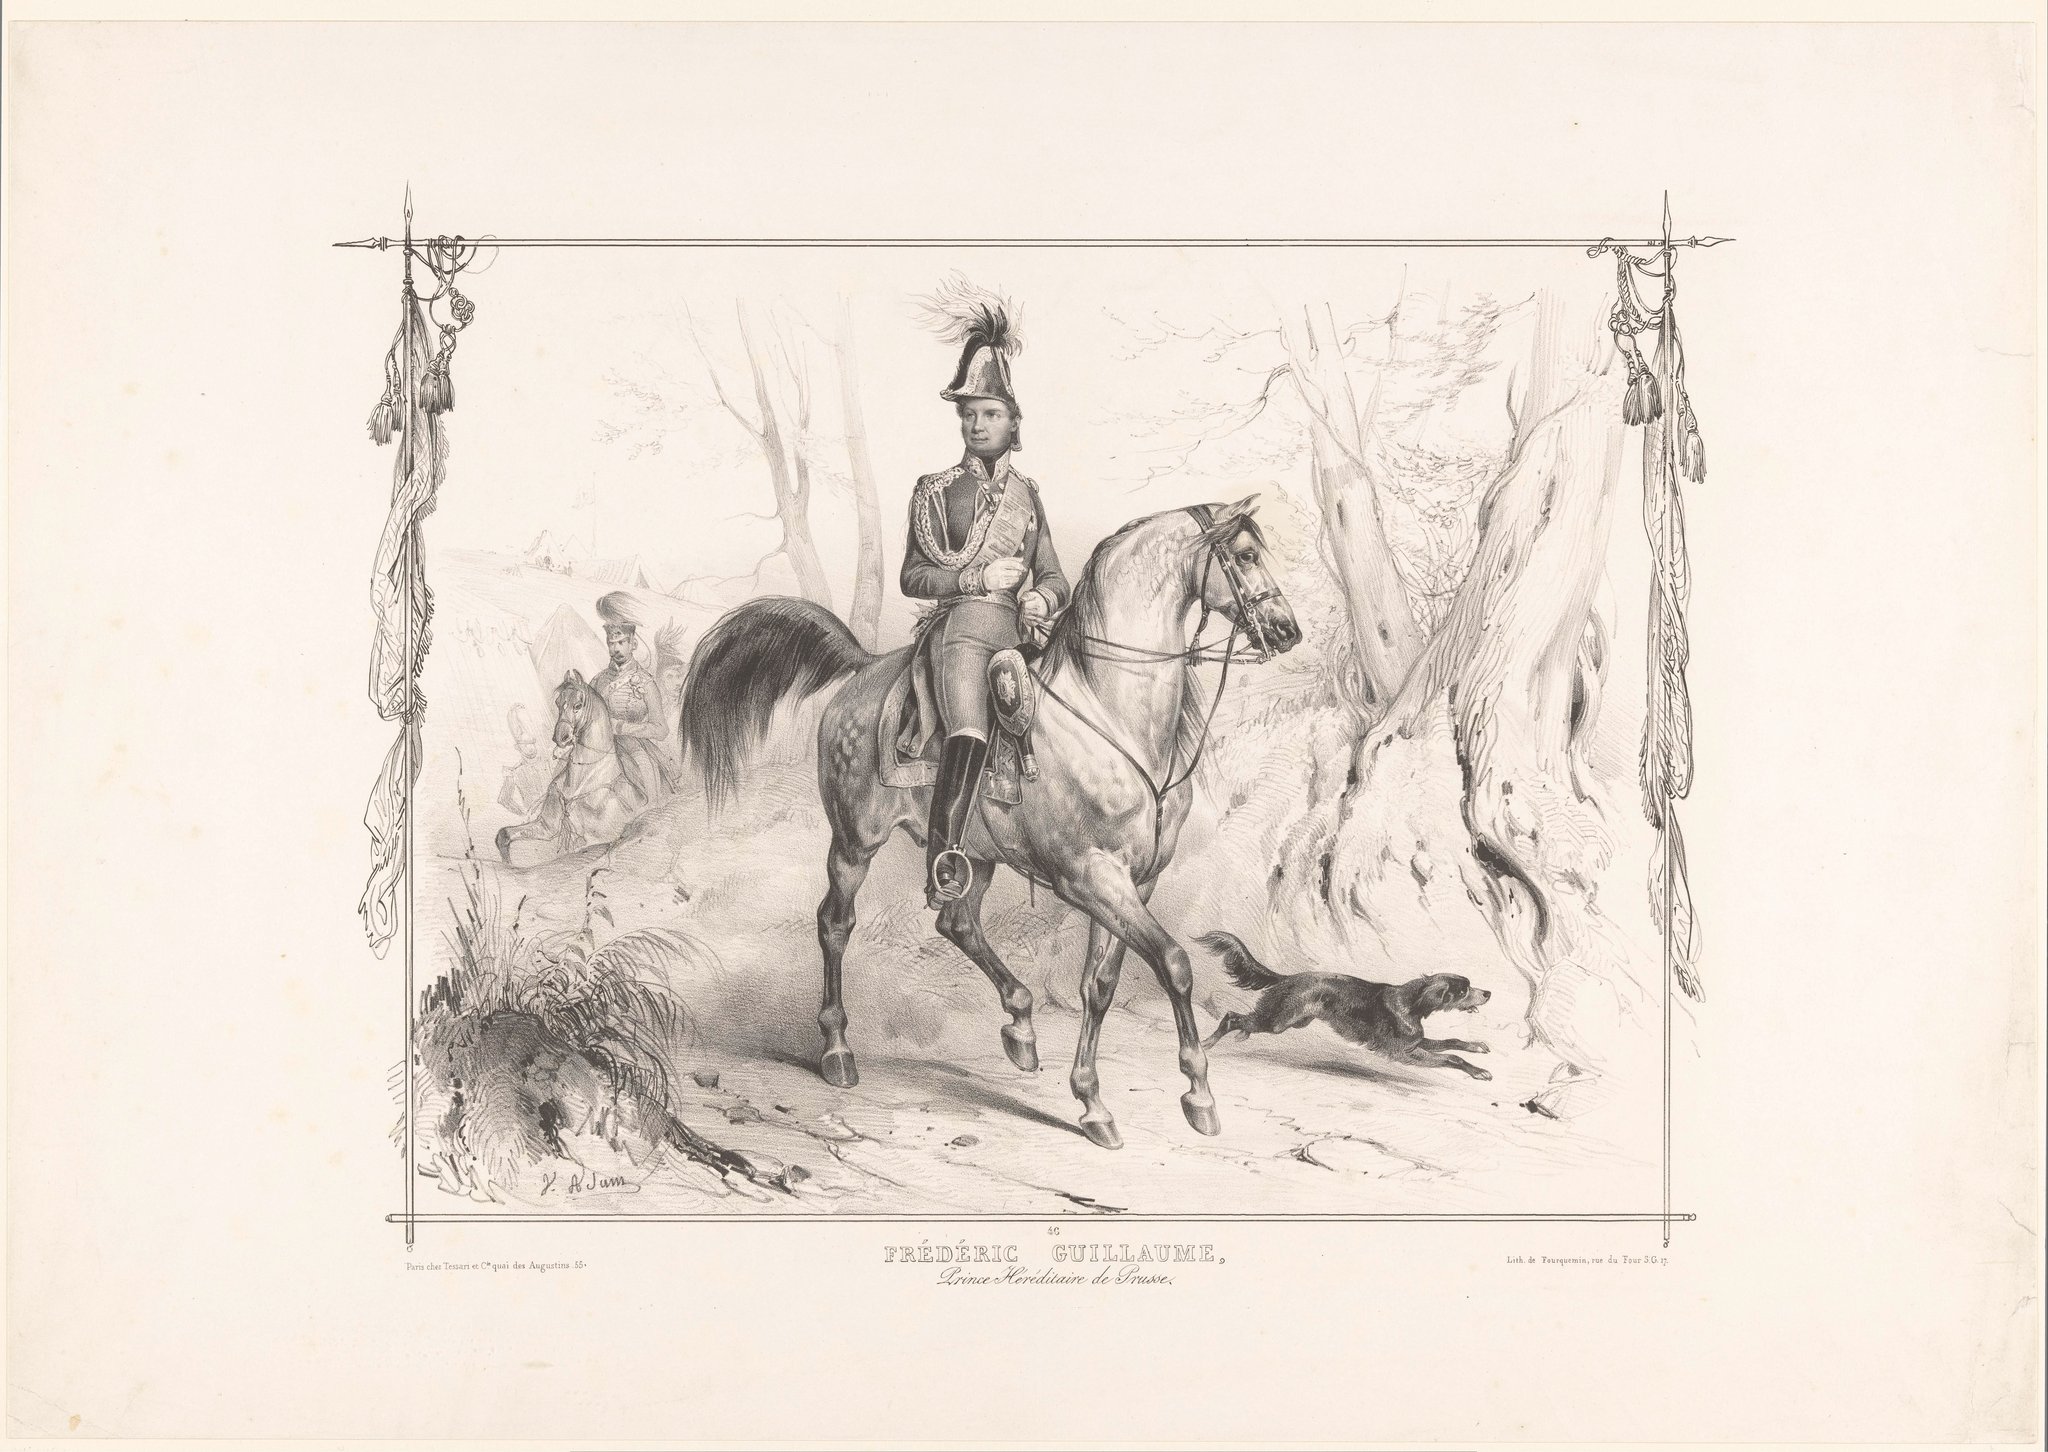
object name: print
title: Frédéric Guillaume, prince héréditaire de Prusse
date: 1839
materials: paper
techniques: lithograph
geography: paris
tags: frederik willem iv (koning van pruisen), riding a horse, ass, or mule; rider, horseman, historical persons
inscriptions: collector's mark: Lugt 2228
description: Frederik Willem IV, koning van Pruisen, zit te paard. In de achtergrond een legerkamp en een aantal Pruisische militairen te paard.